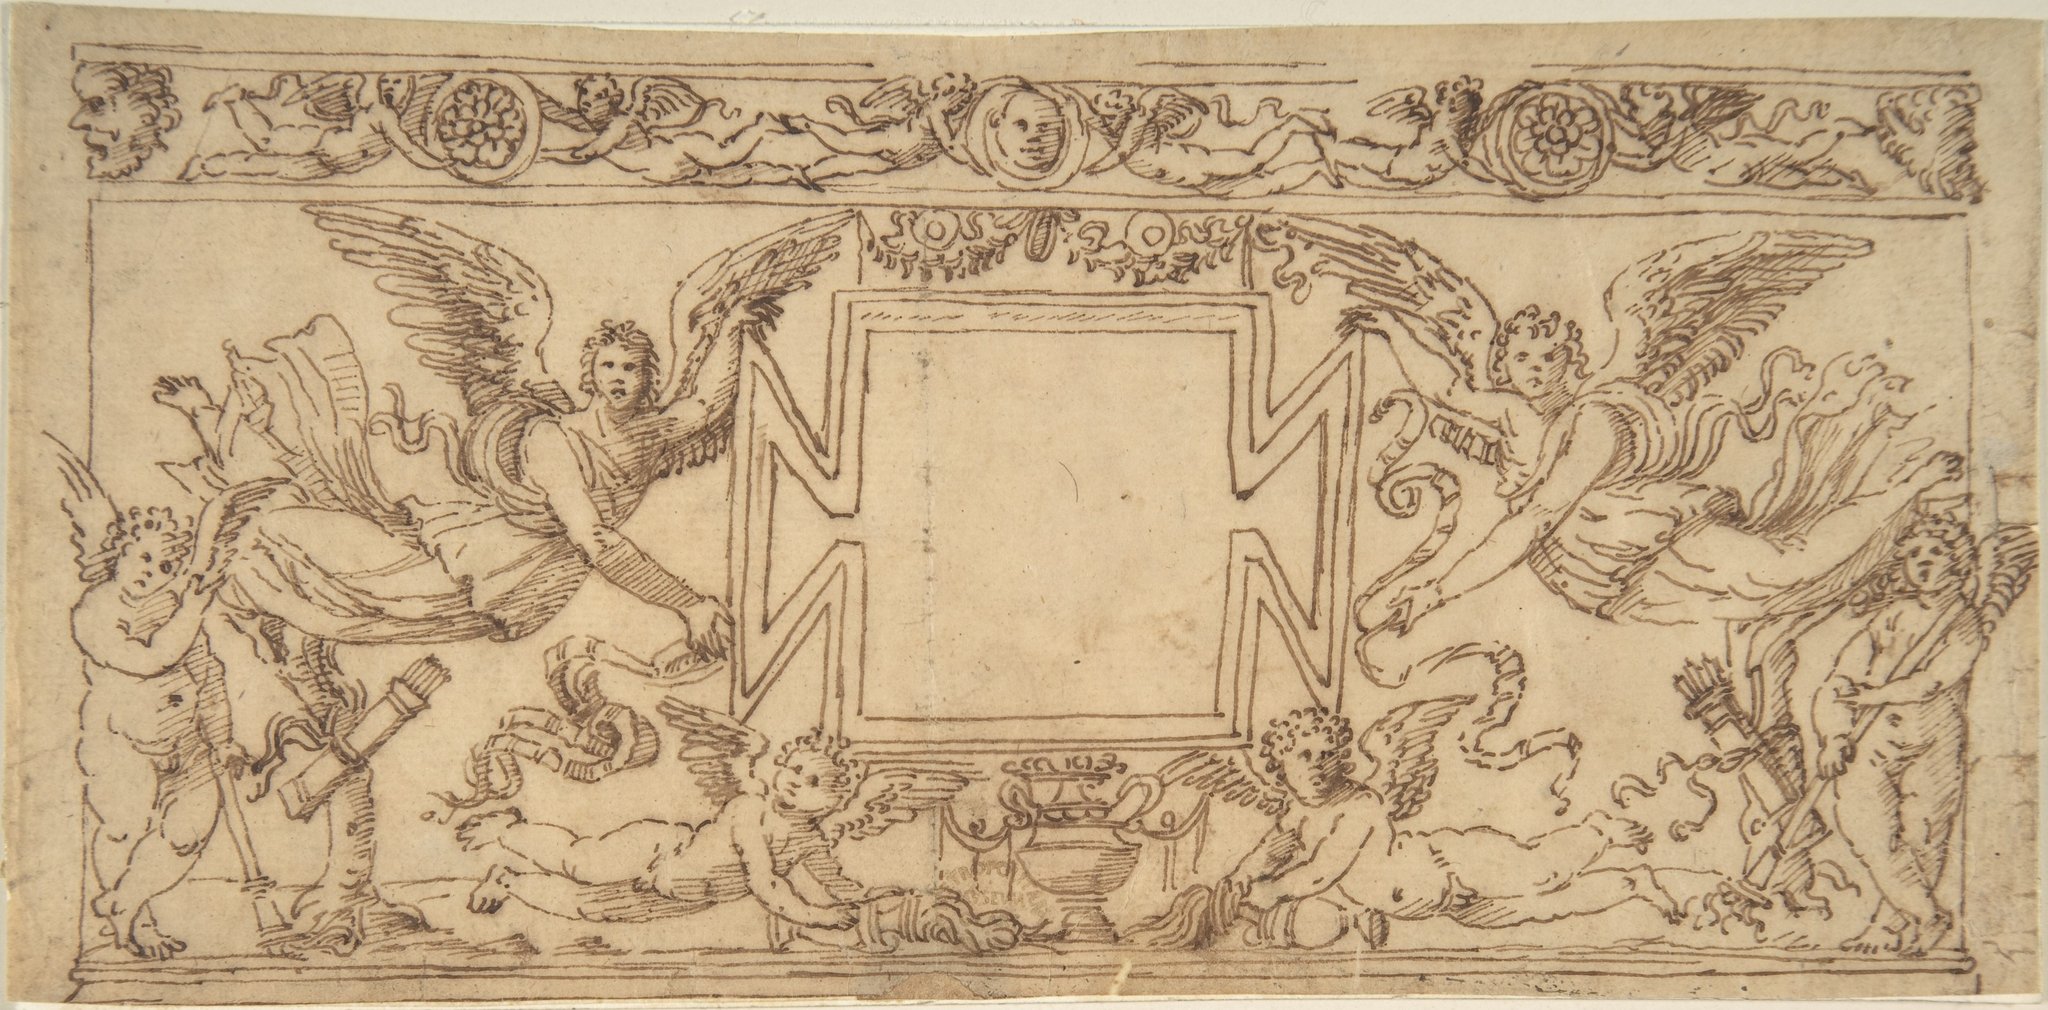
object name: drawing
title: Sarcophagus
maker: anonymous, italian, 16th century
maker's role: artist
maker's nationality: italian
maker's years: 1550-1600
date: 1501-1600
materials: ink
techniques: pen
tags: putti,angels